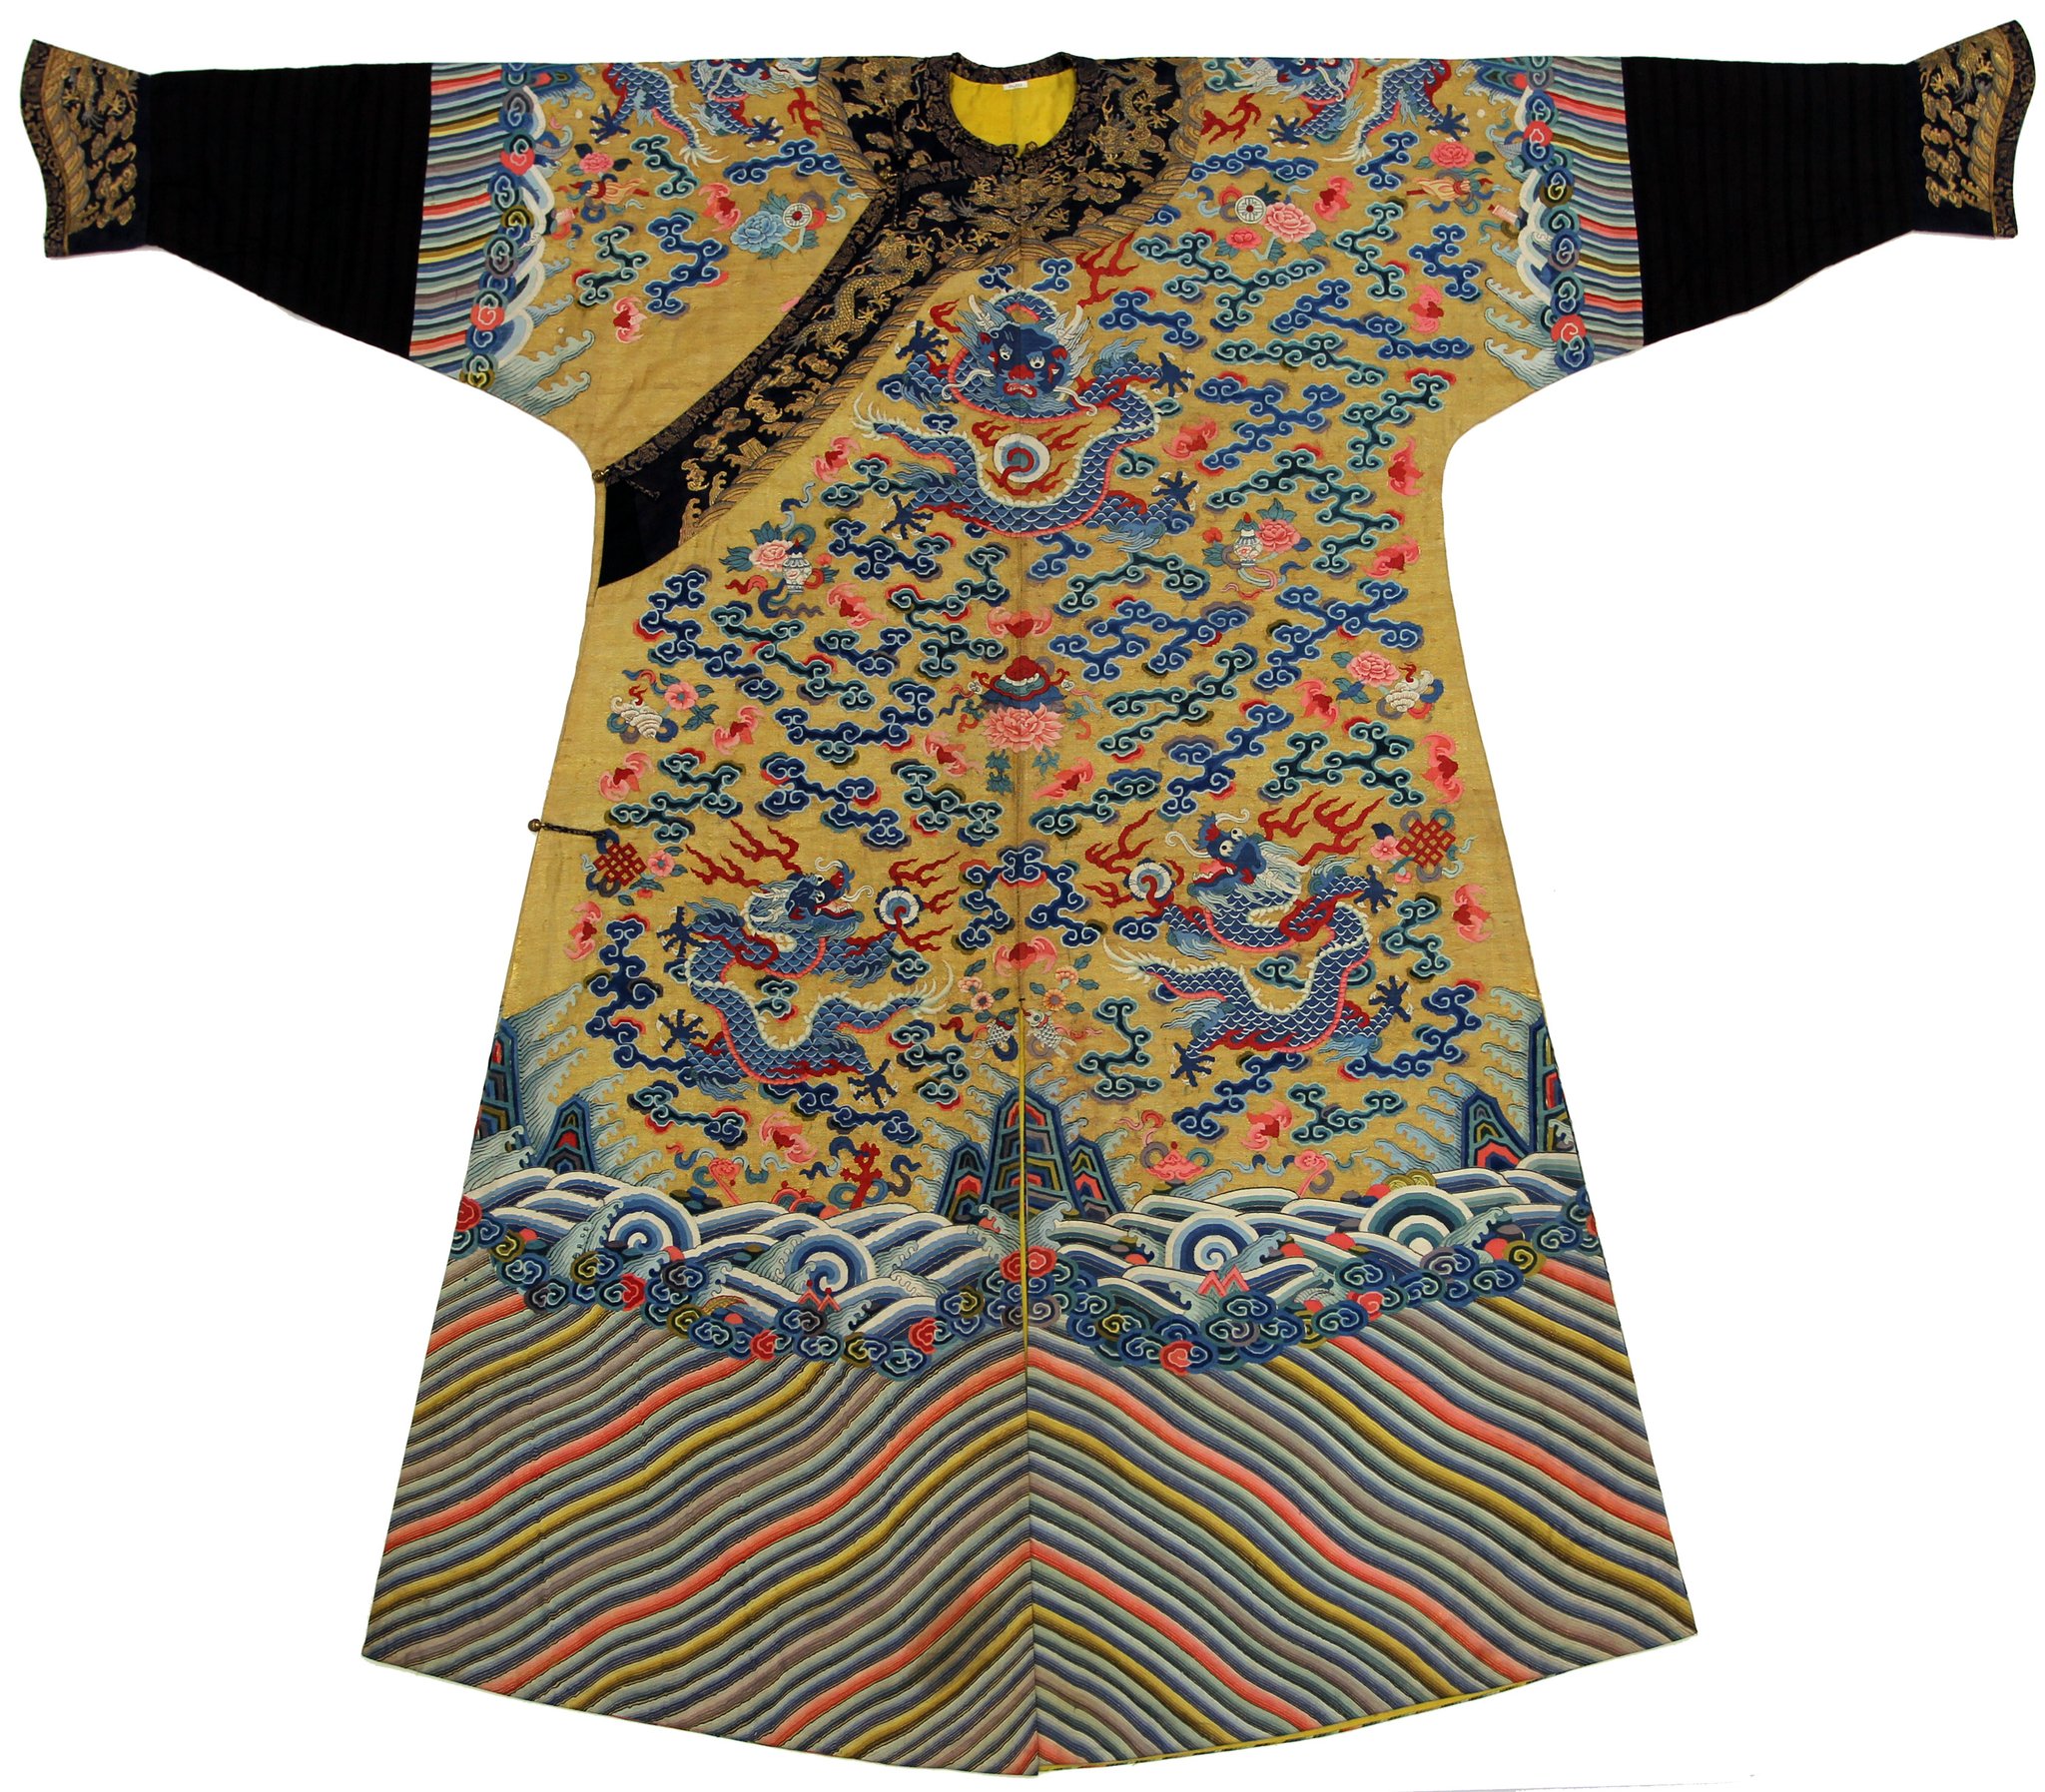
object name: robe, imperial court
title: Imperial Court Robe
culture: chinese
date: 1875-1908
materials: metal thread, silk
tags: dragons,flowers